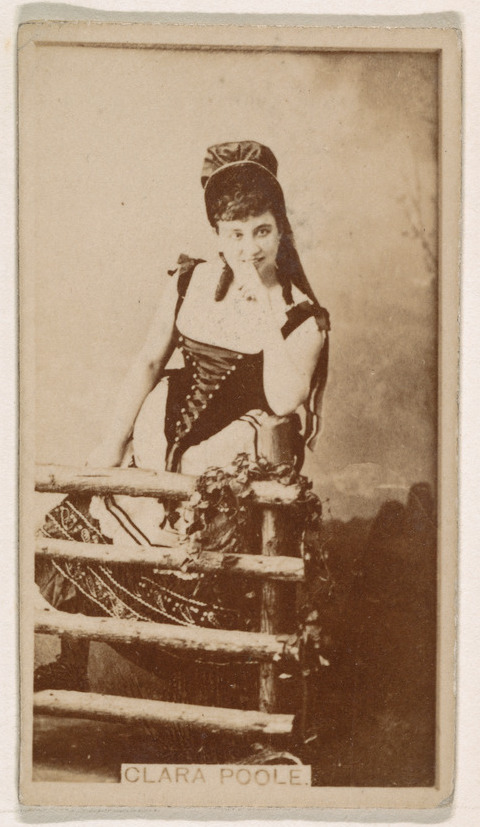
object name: photograph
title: Clara Poole, from the Actresses series (N245) issued by Kinney Brothers to promote Sweet Caporal Cigarettes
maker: kinney brothers tobacco company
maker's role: publisher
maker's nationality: american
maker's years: 1869-2011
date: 1890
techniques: albumen silver print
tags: portraits,women,actresses